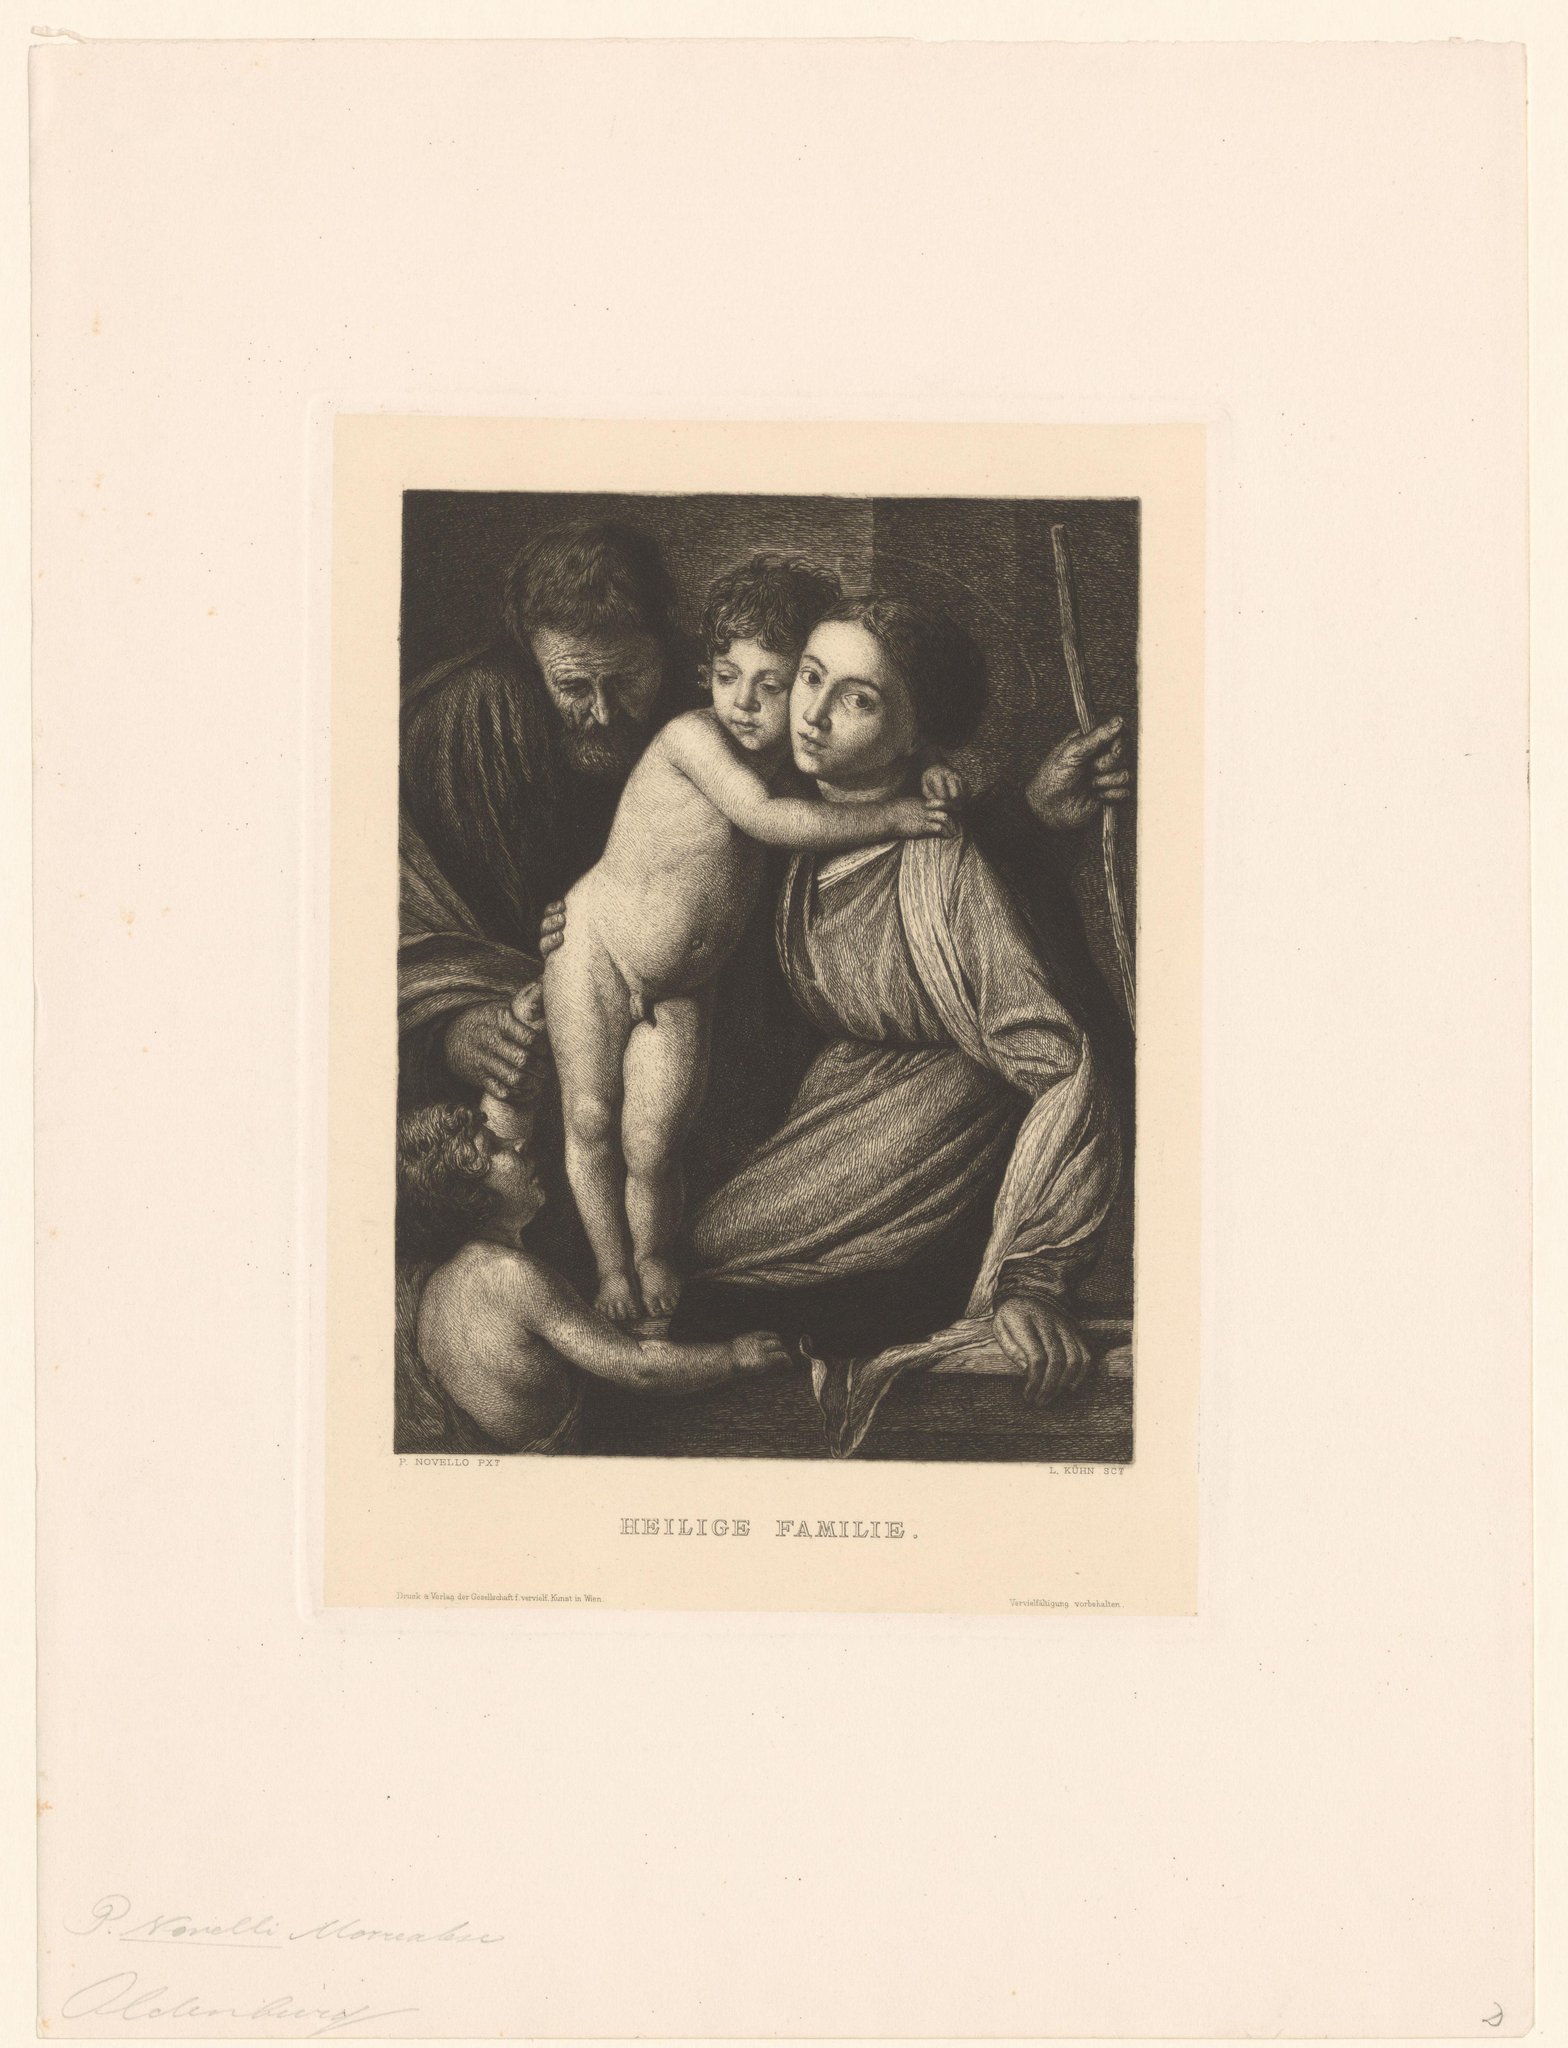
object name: print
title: Heilige Familie met Johannes de Doper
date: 1871-1934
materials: paper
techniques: engraving, etching, intaglio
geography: vienna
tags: holy family with john the baptist (as child)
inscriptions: collector's mark: Lugt 2228